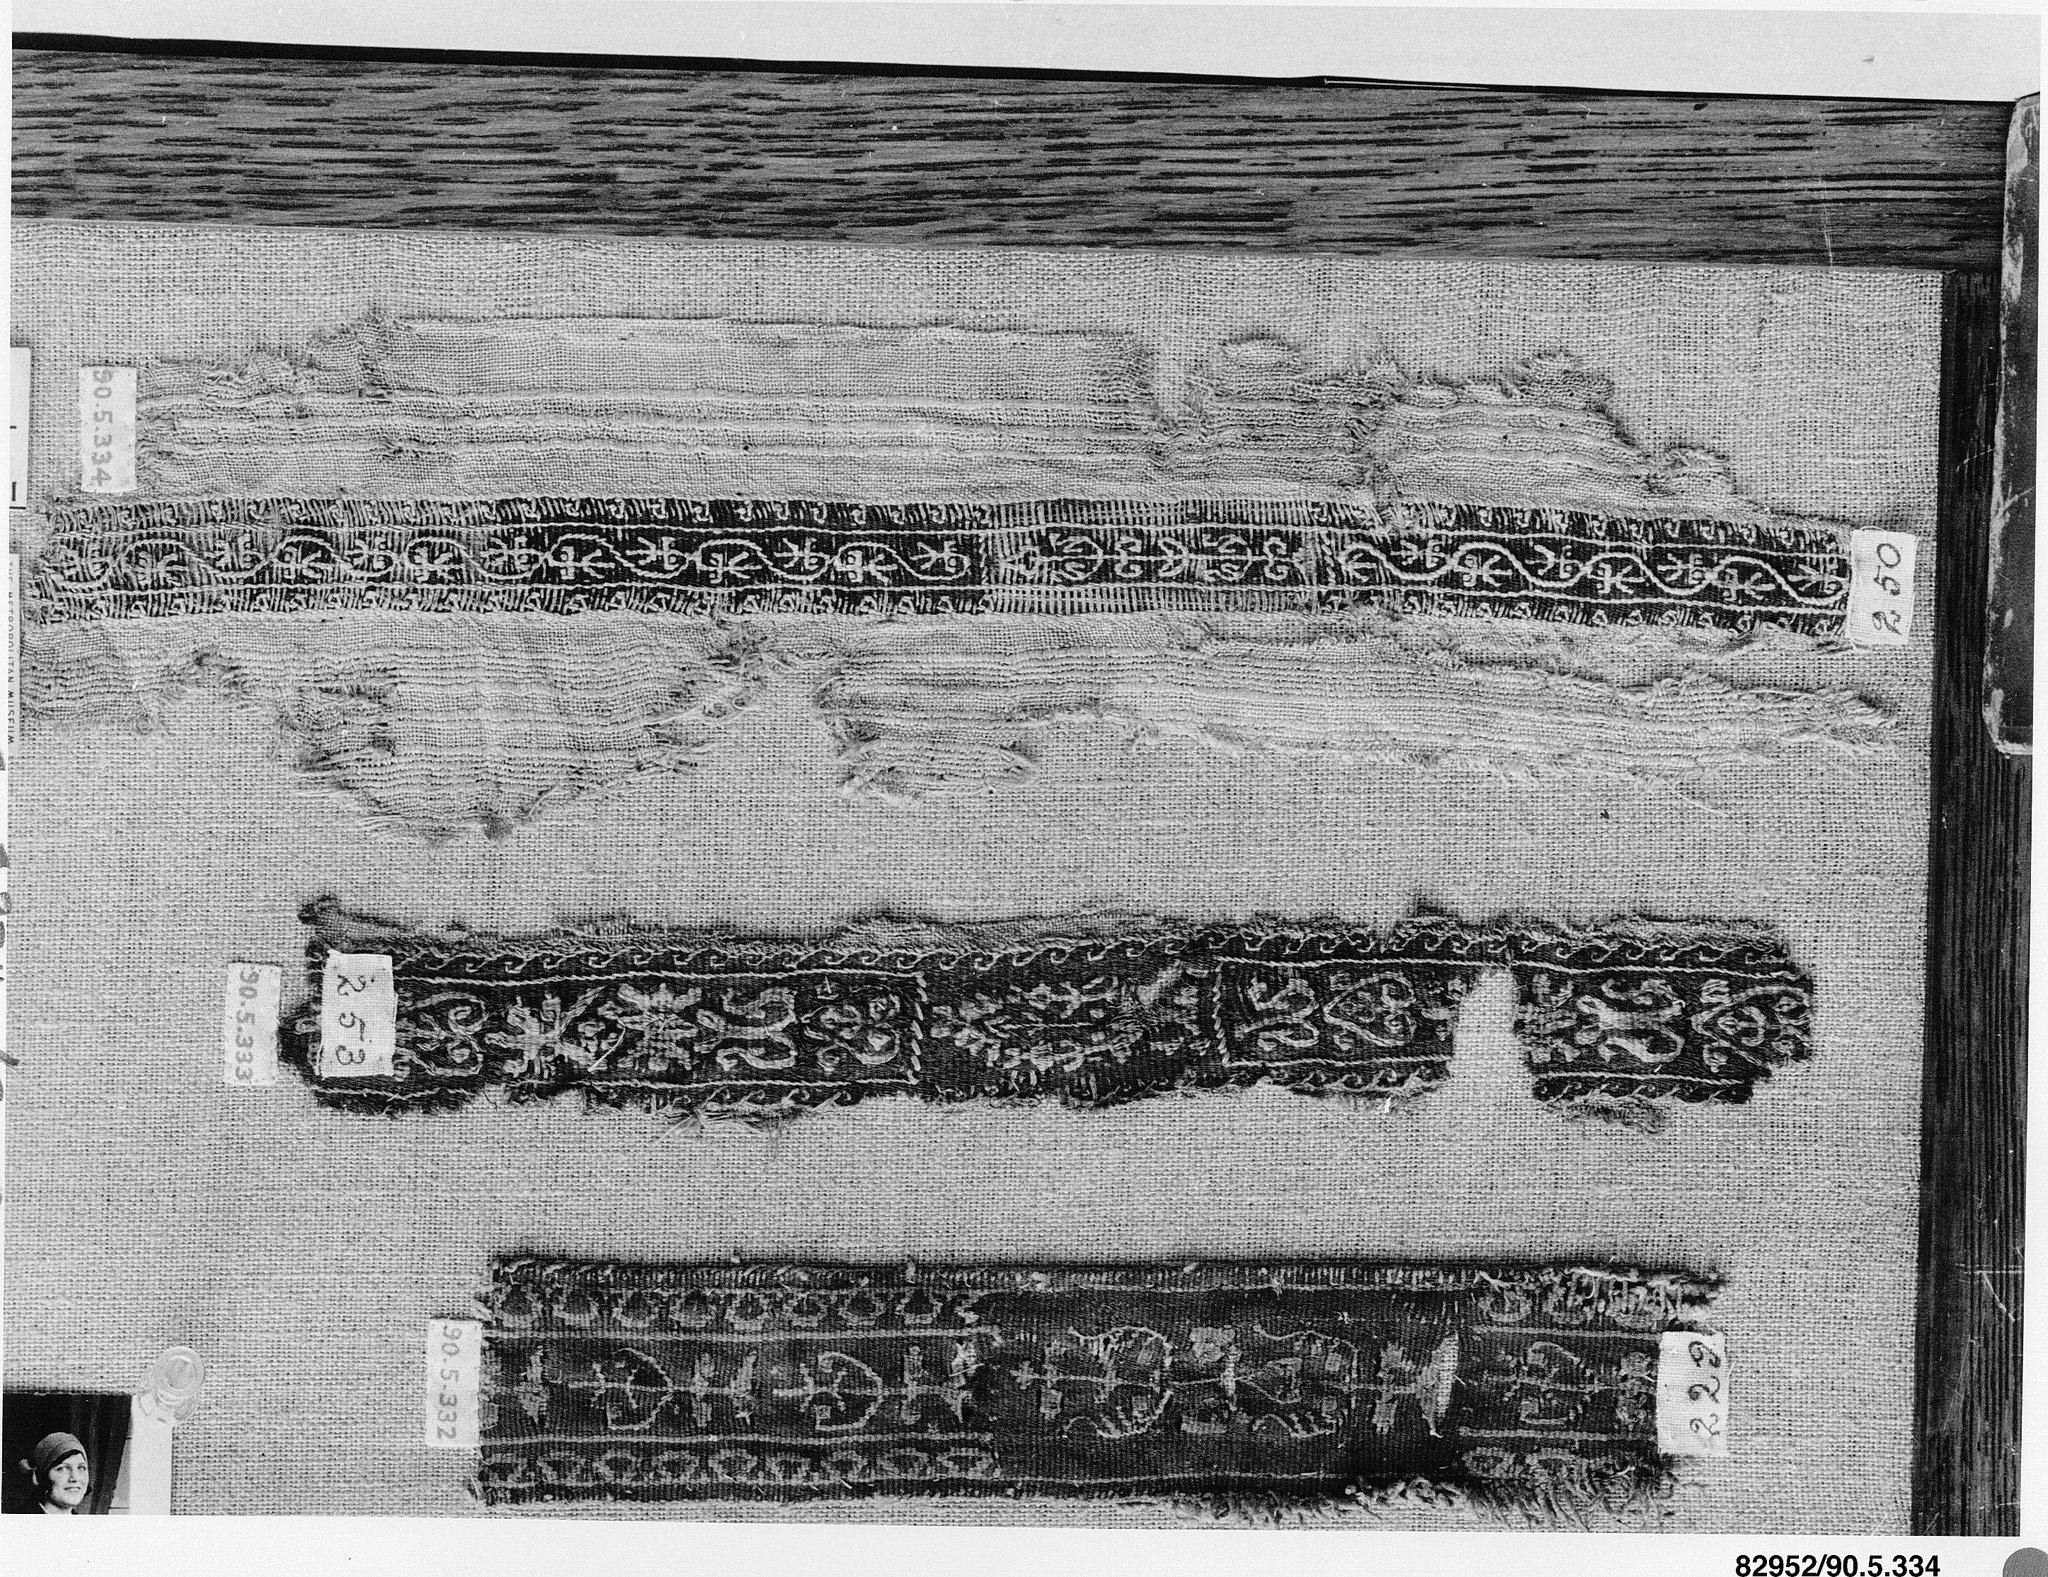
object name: textile fragment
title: Fragment of a Tunic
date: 301-500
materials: linen, wool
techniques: weave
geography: egypt